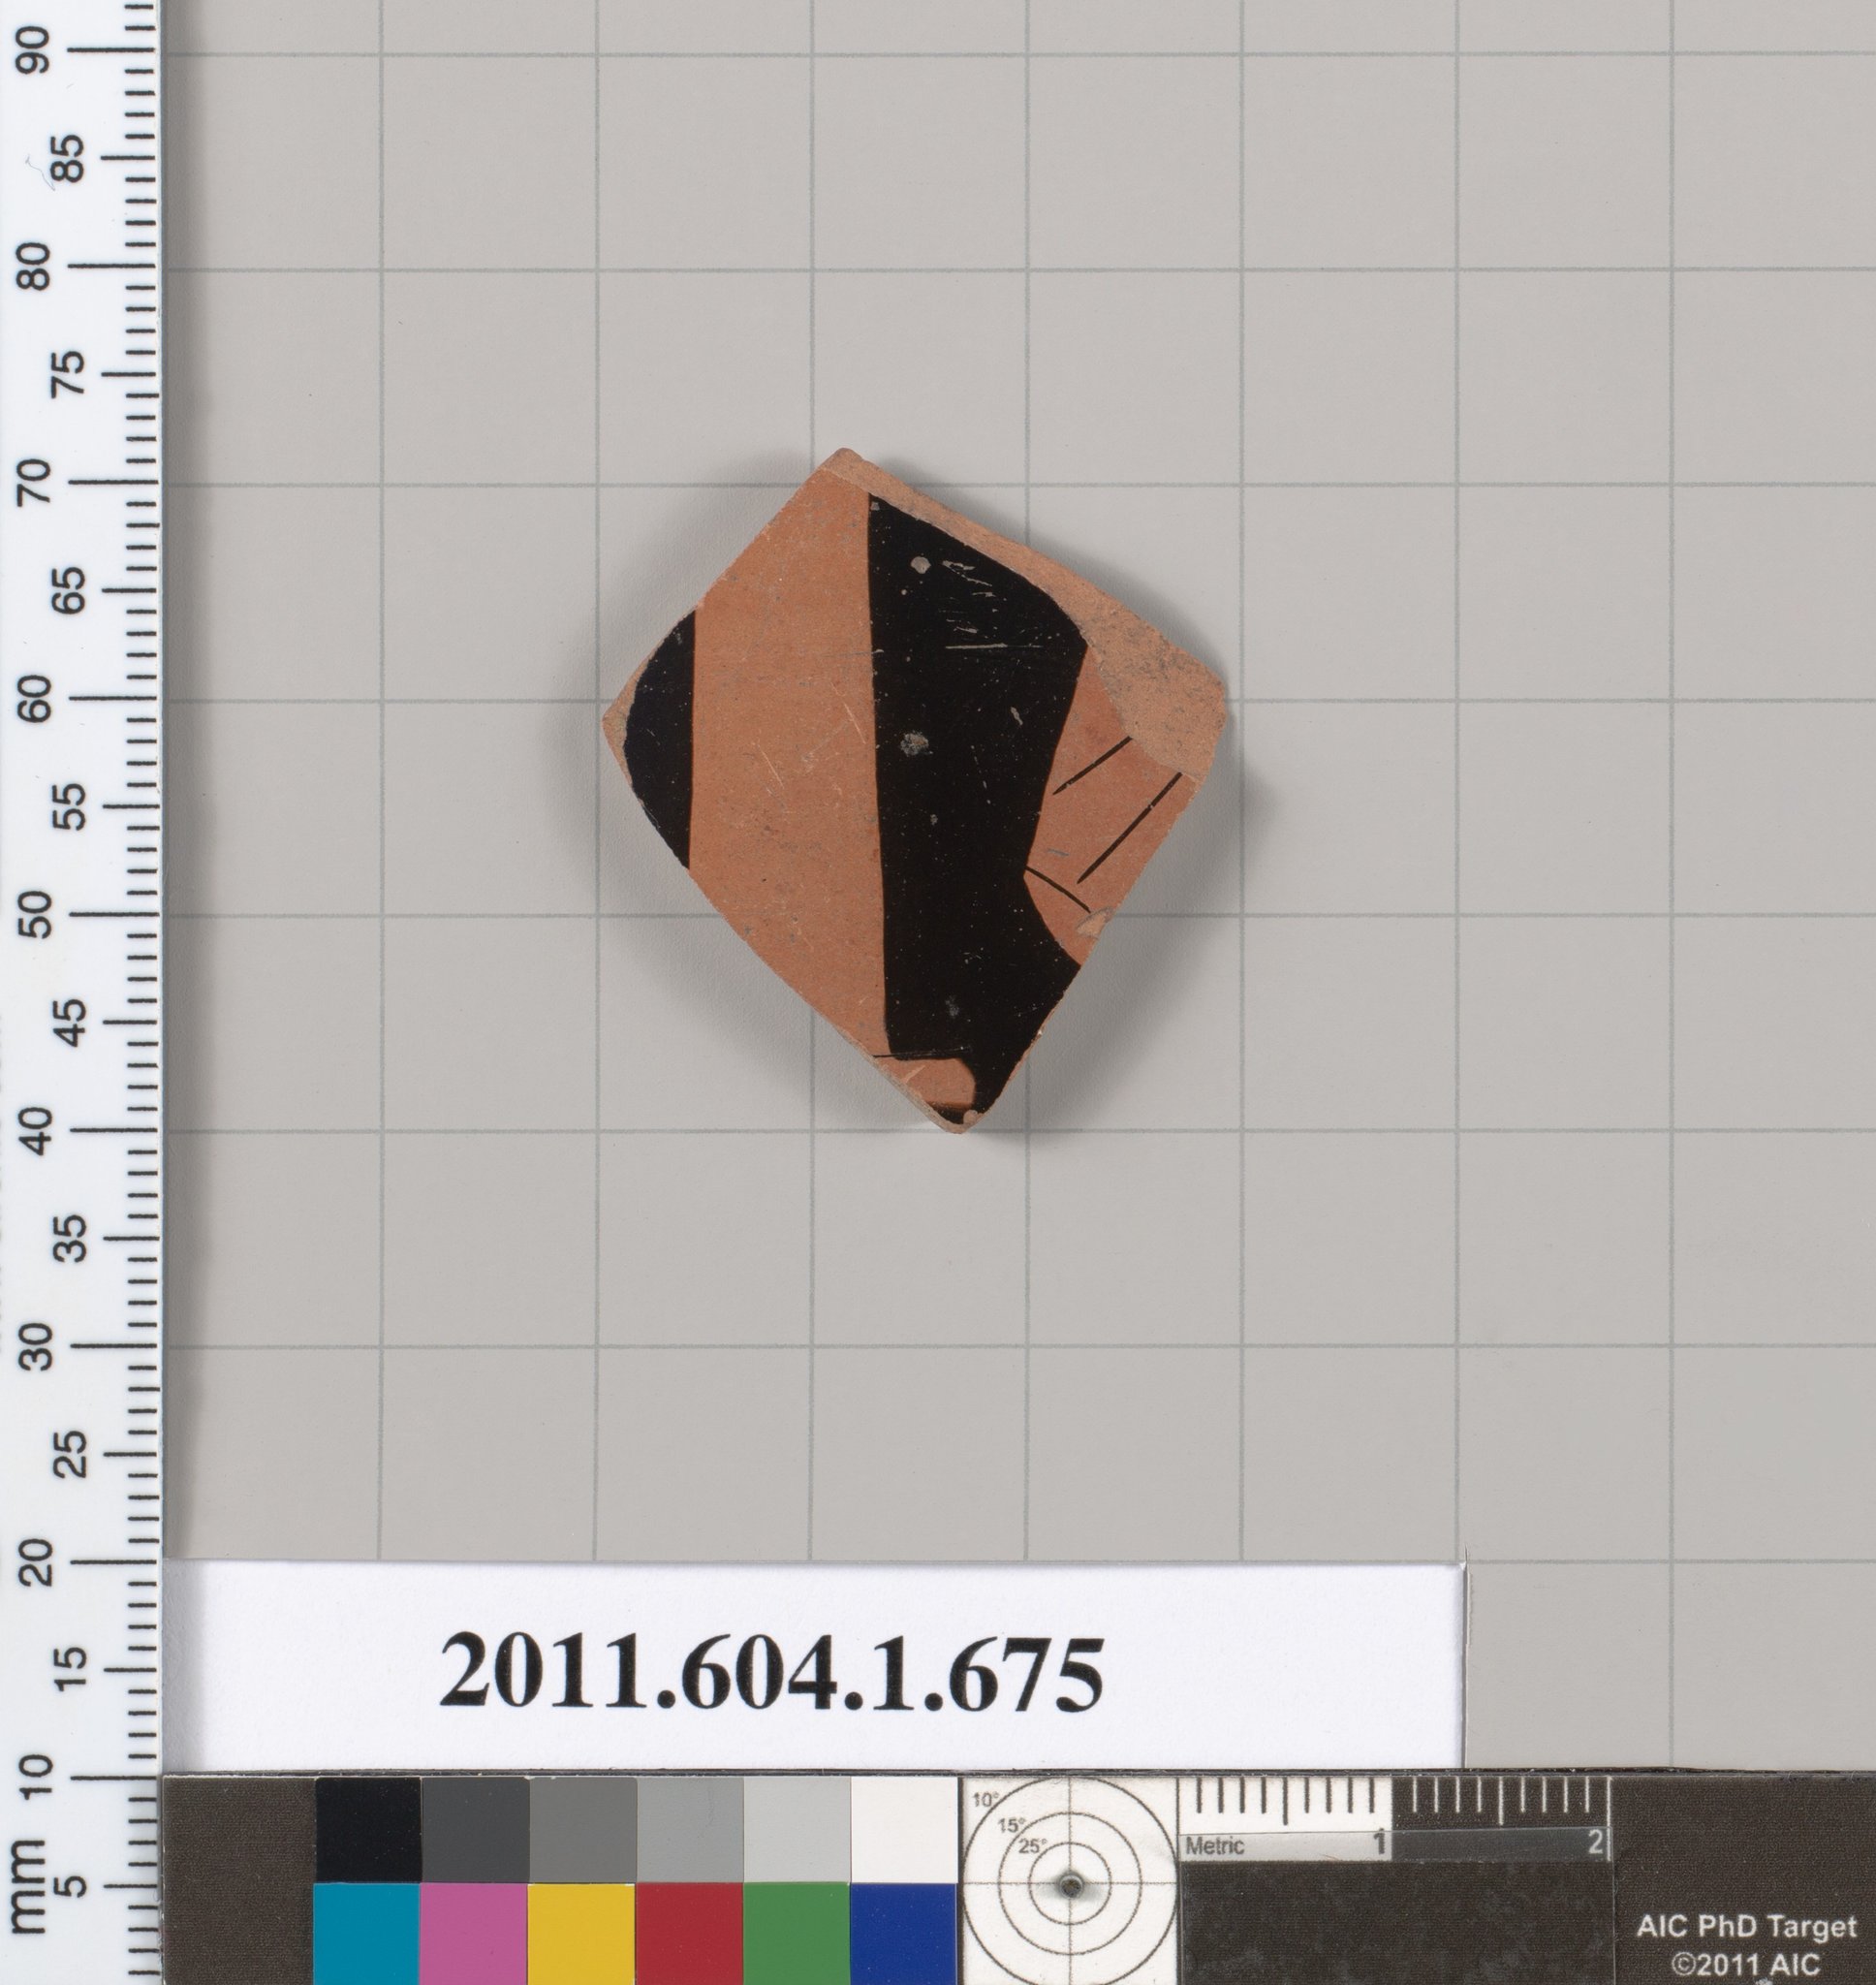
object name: kylix fragment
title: Terracotta fragment of a kylix (drinking cup)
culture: greek, attic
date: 500-401 BCE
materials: terracotta